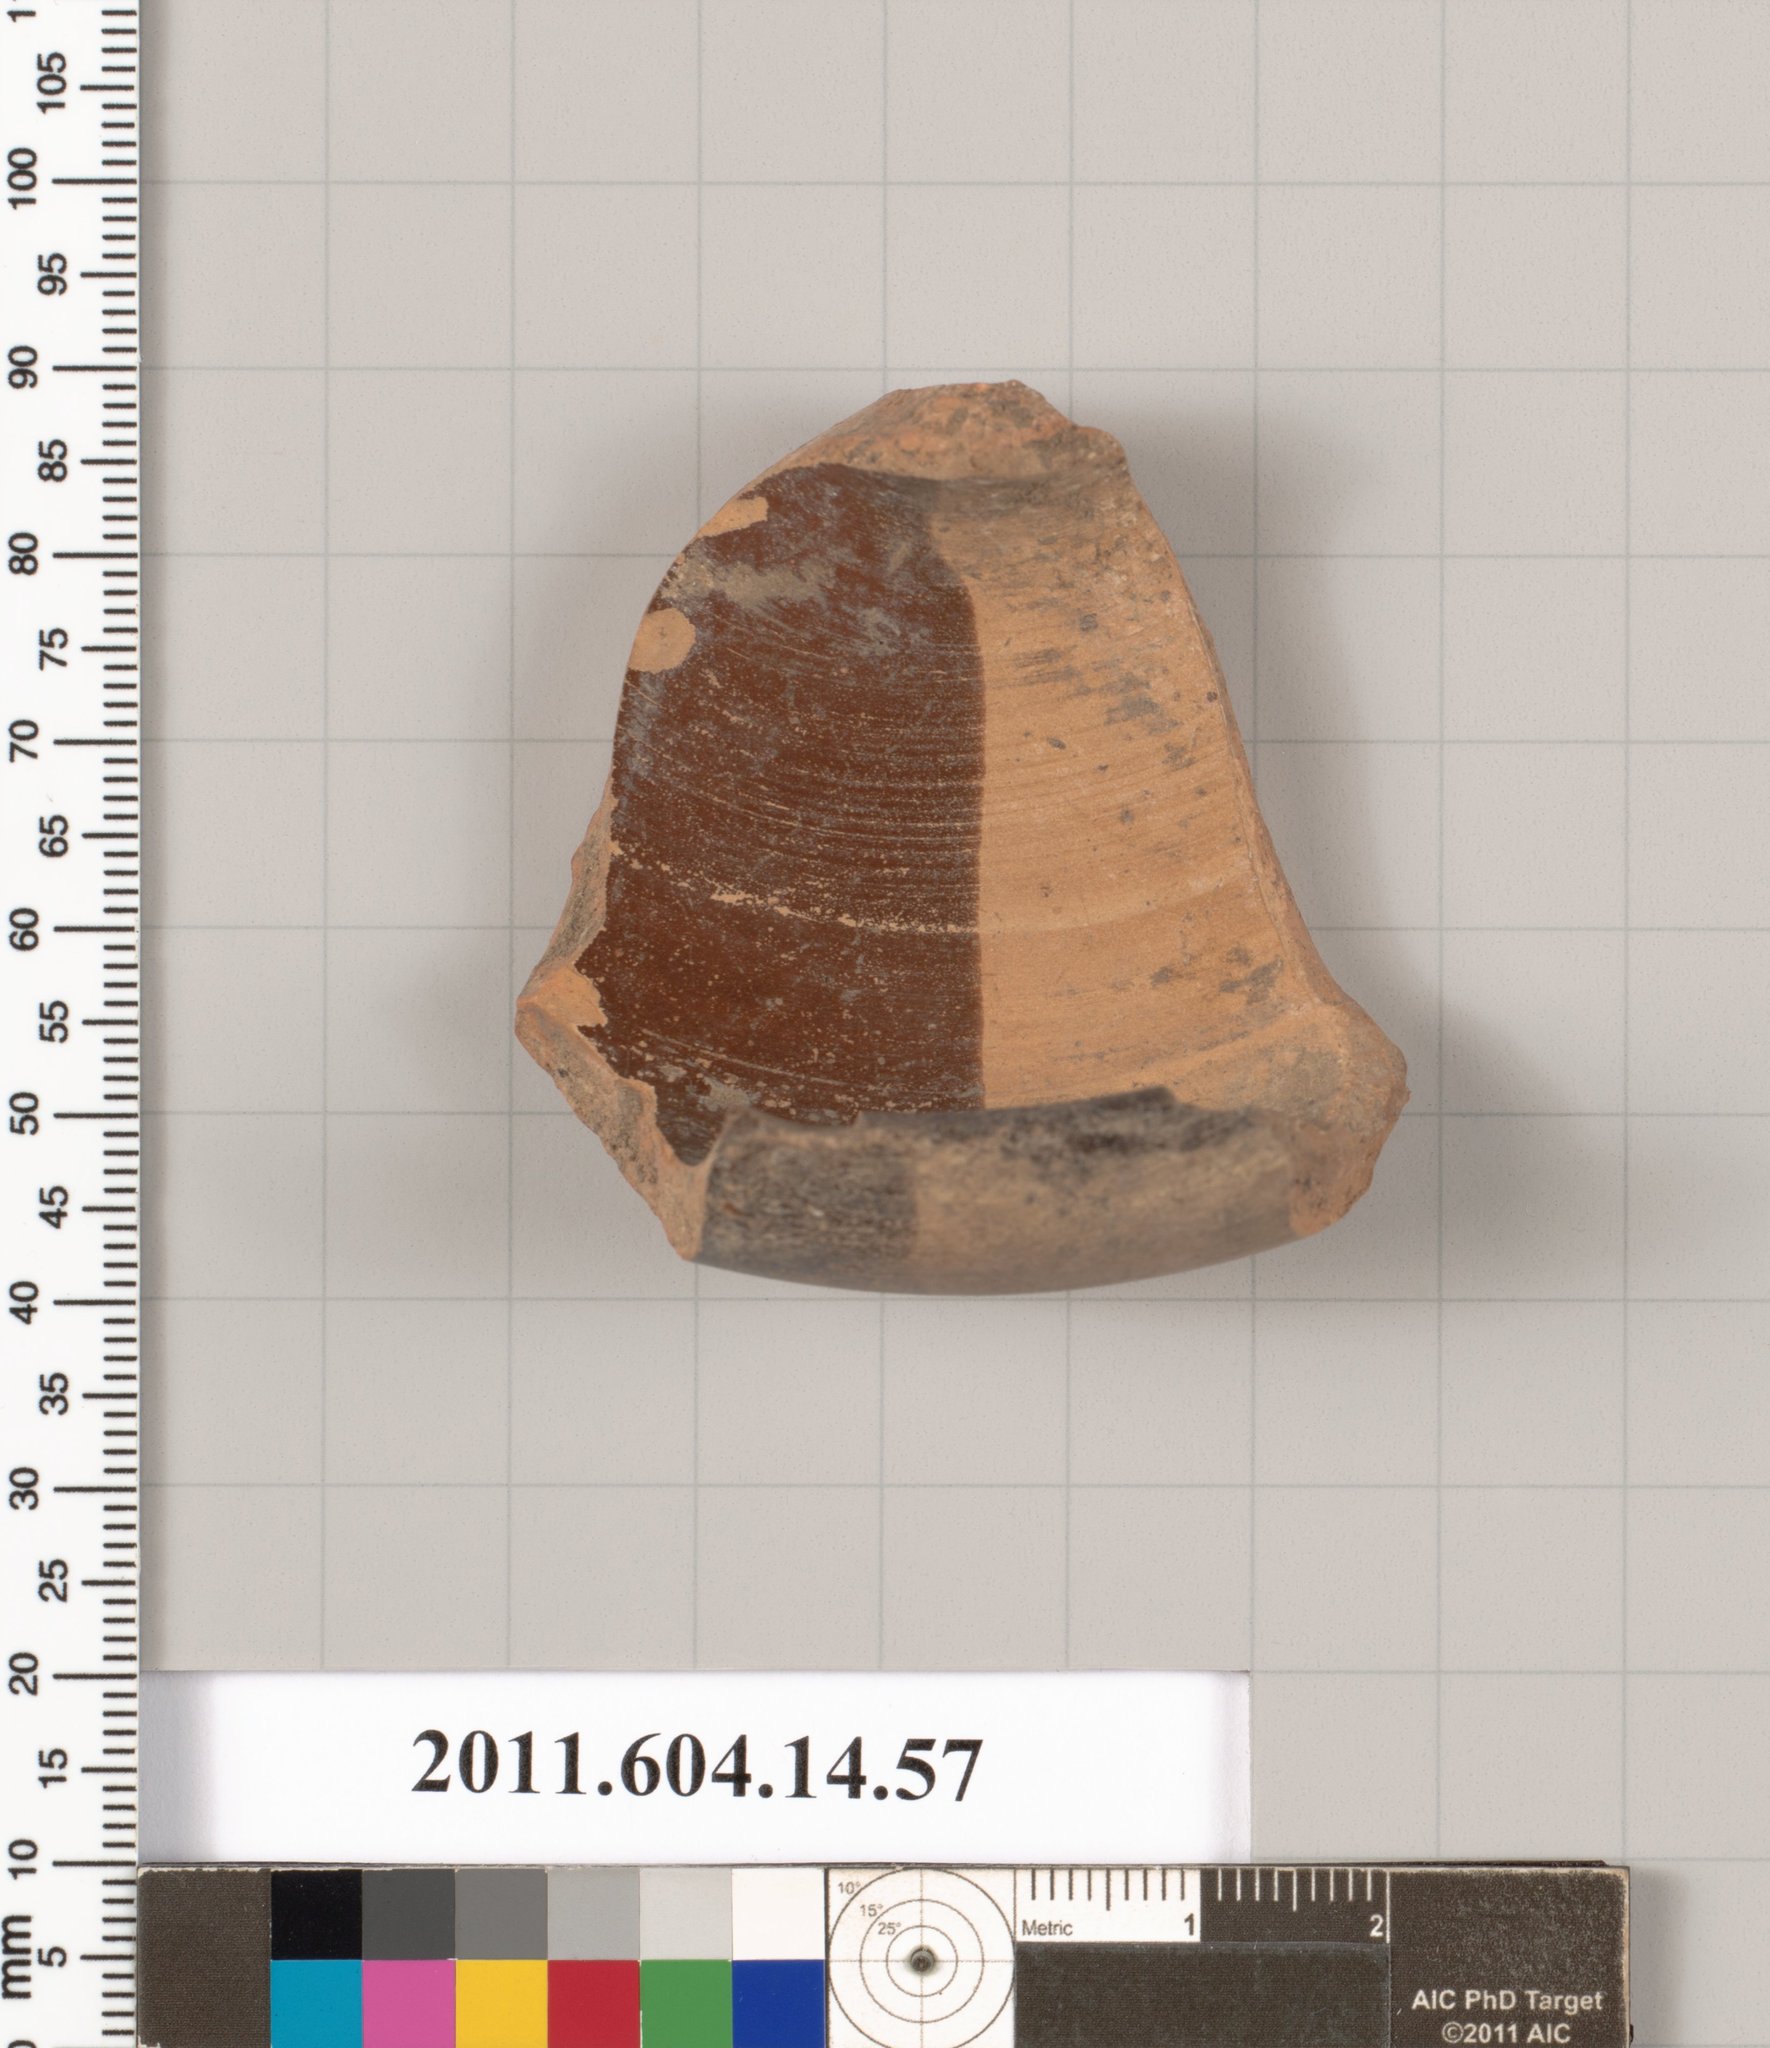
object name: undetermined shape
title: Terracotta fragment of an undetermined shape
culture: unknown fabric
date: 600-301 BCE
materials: terracotta